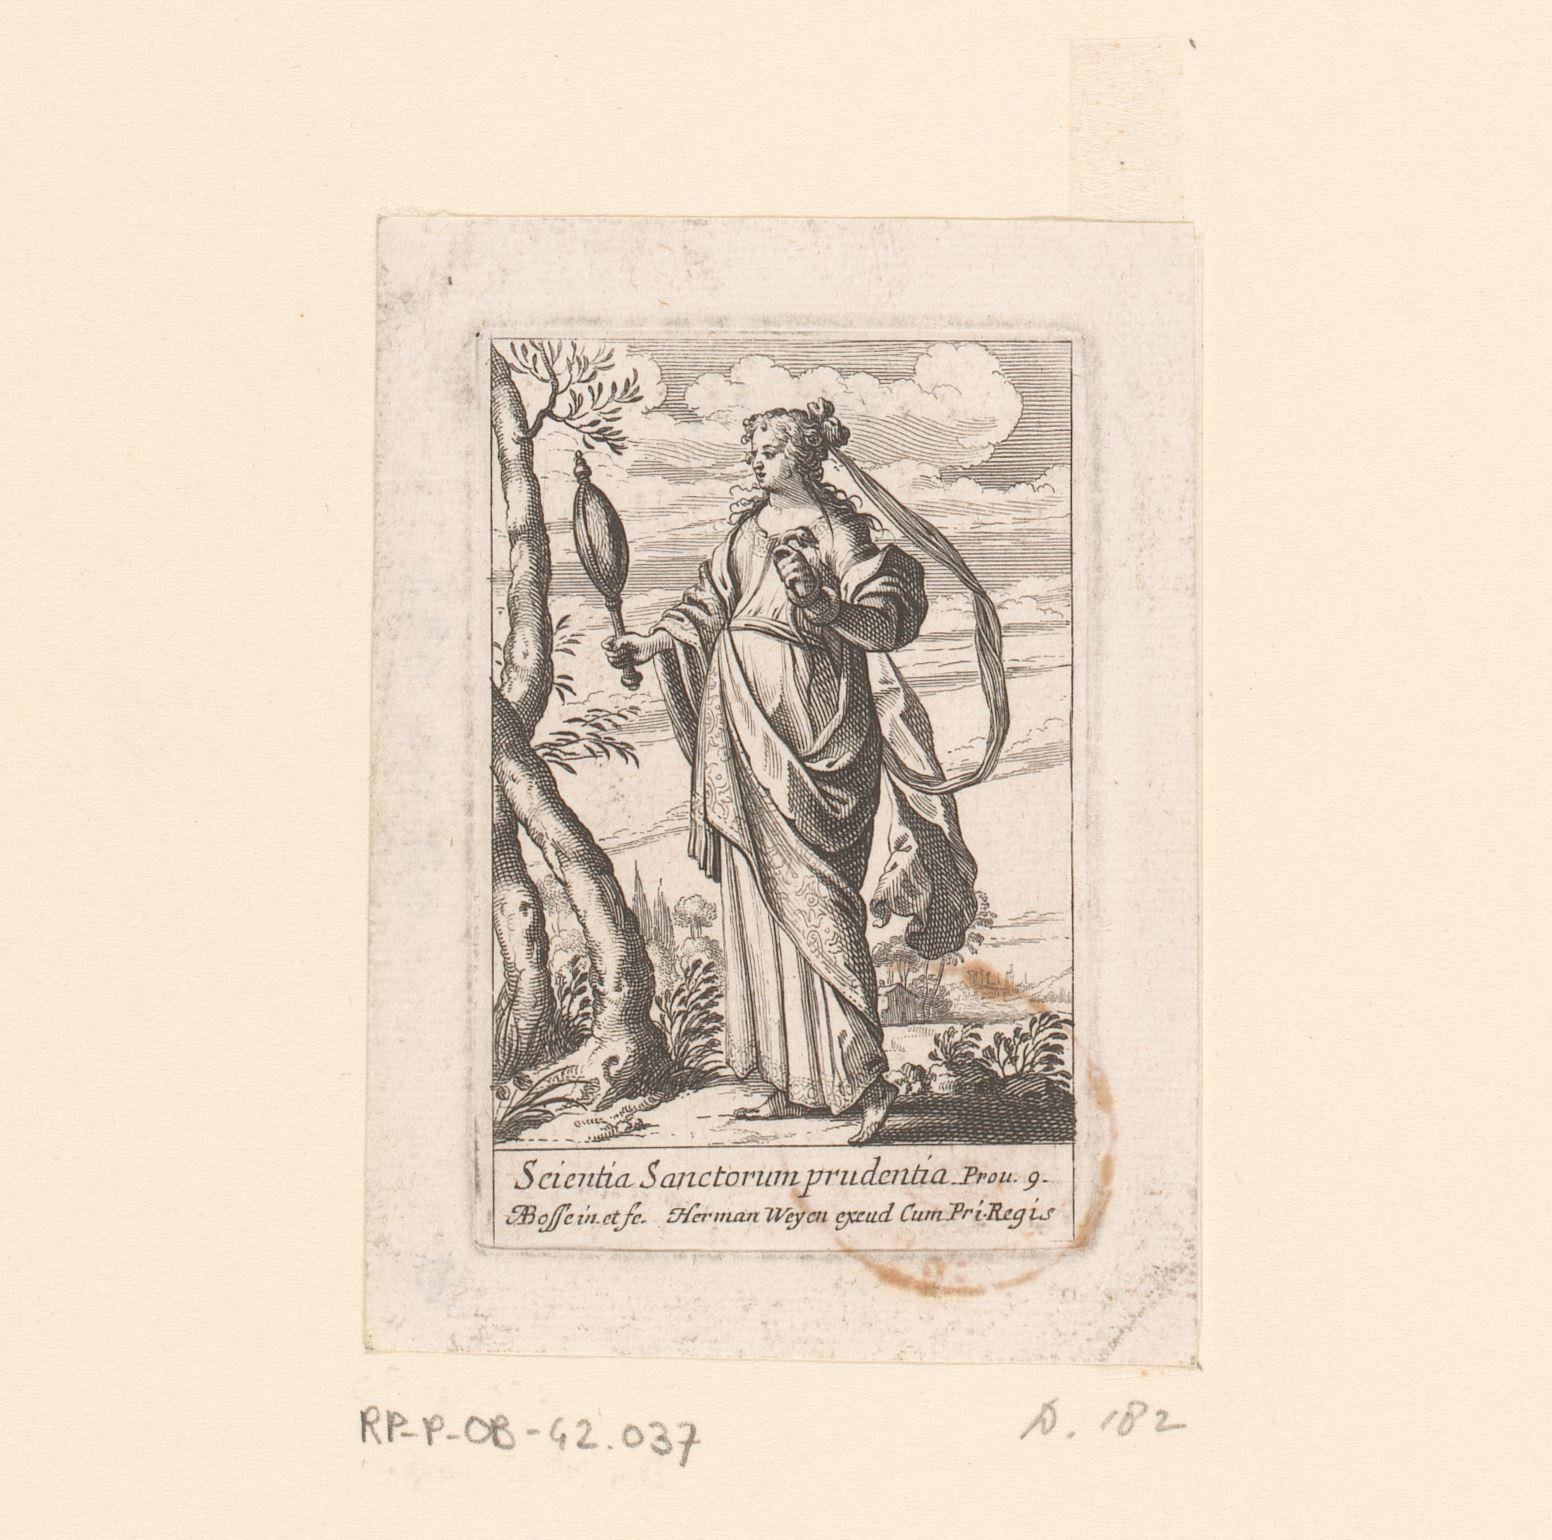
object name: print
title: Personificaties van deugden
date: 1636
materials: paper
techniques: engraving, etching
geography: paris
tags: prudence, 'prudentia'; 'prudenza' (ripa) ~ one of the four cardinal virtues, mirror, the seven virtues (symbolized)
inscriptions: collector's mark: Lugt 240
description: Maakt deel uit van een serie van negen prenten (inclusief twee titelprenten) met personificaties van de zeven deugden.